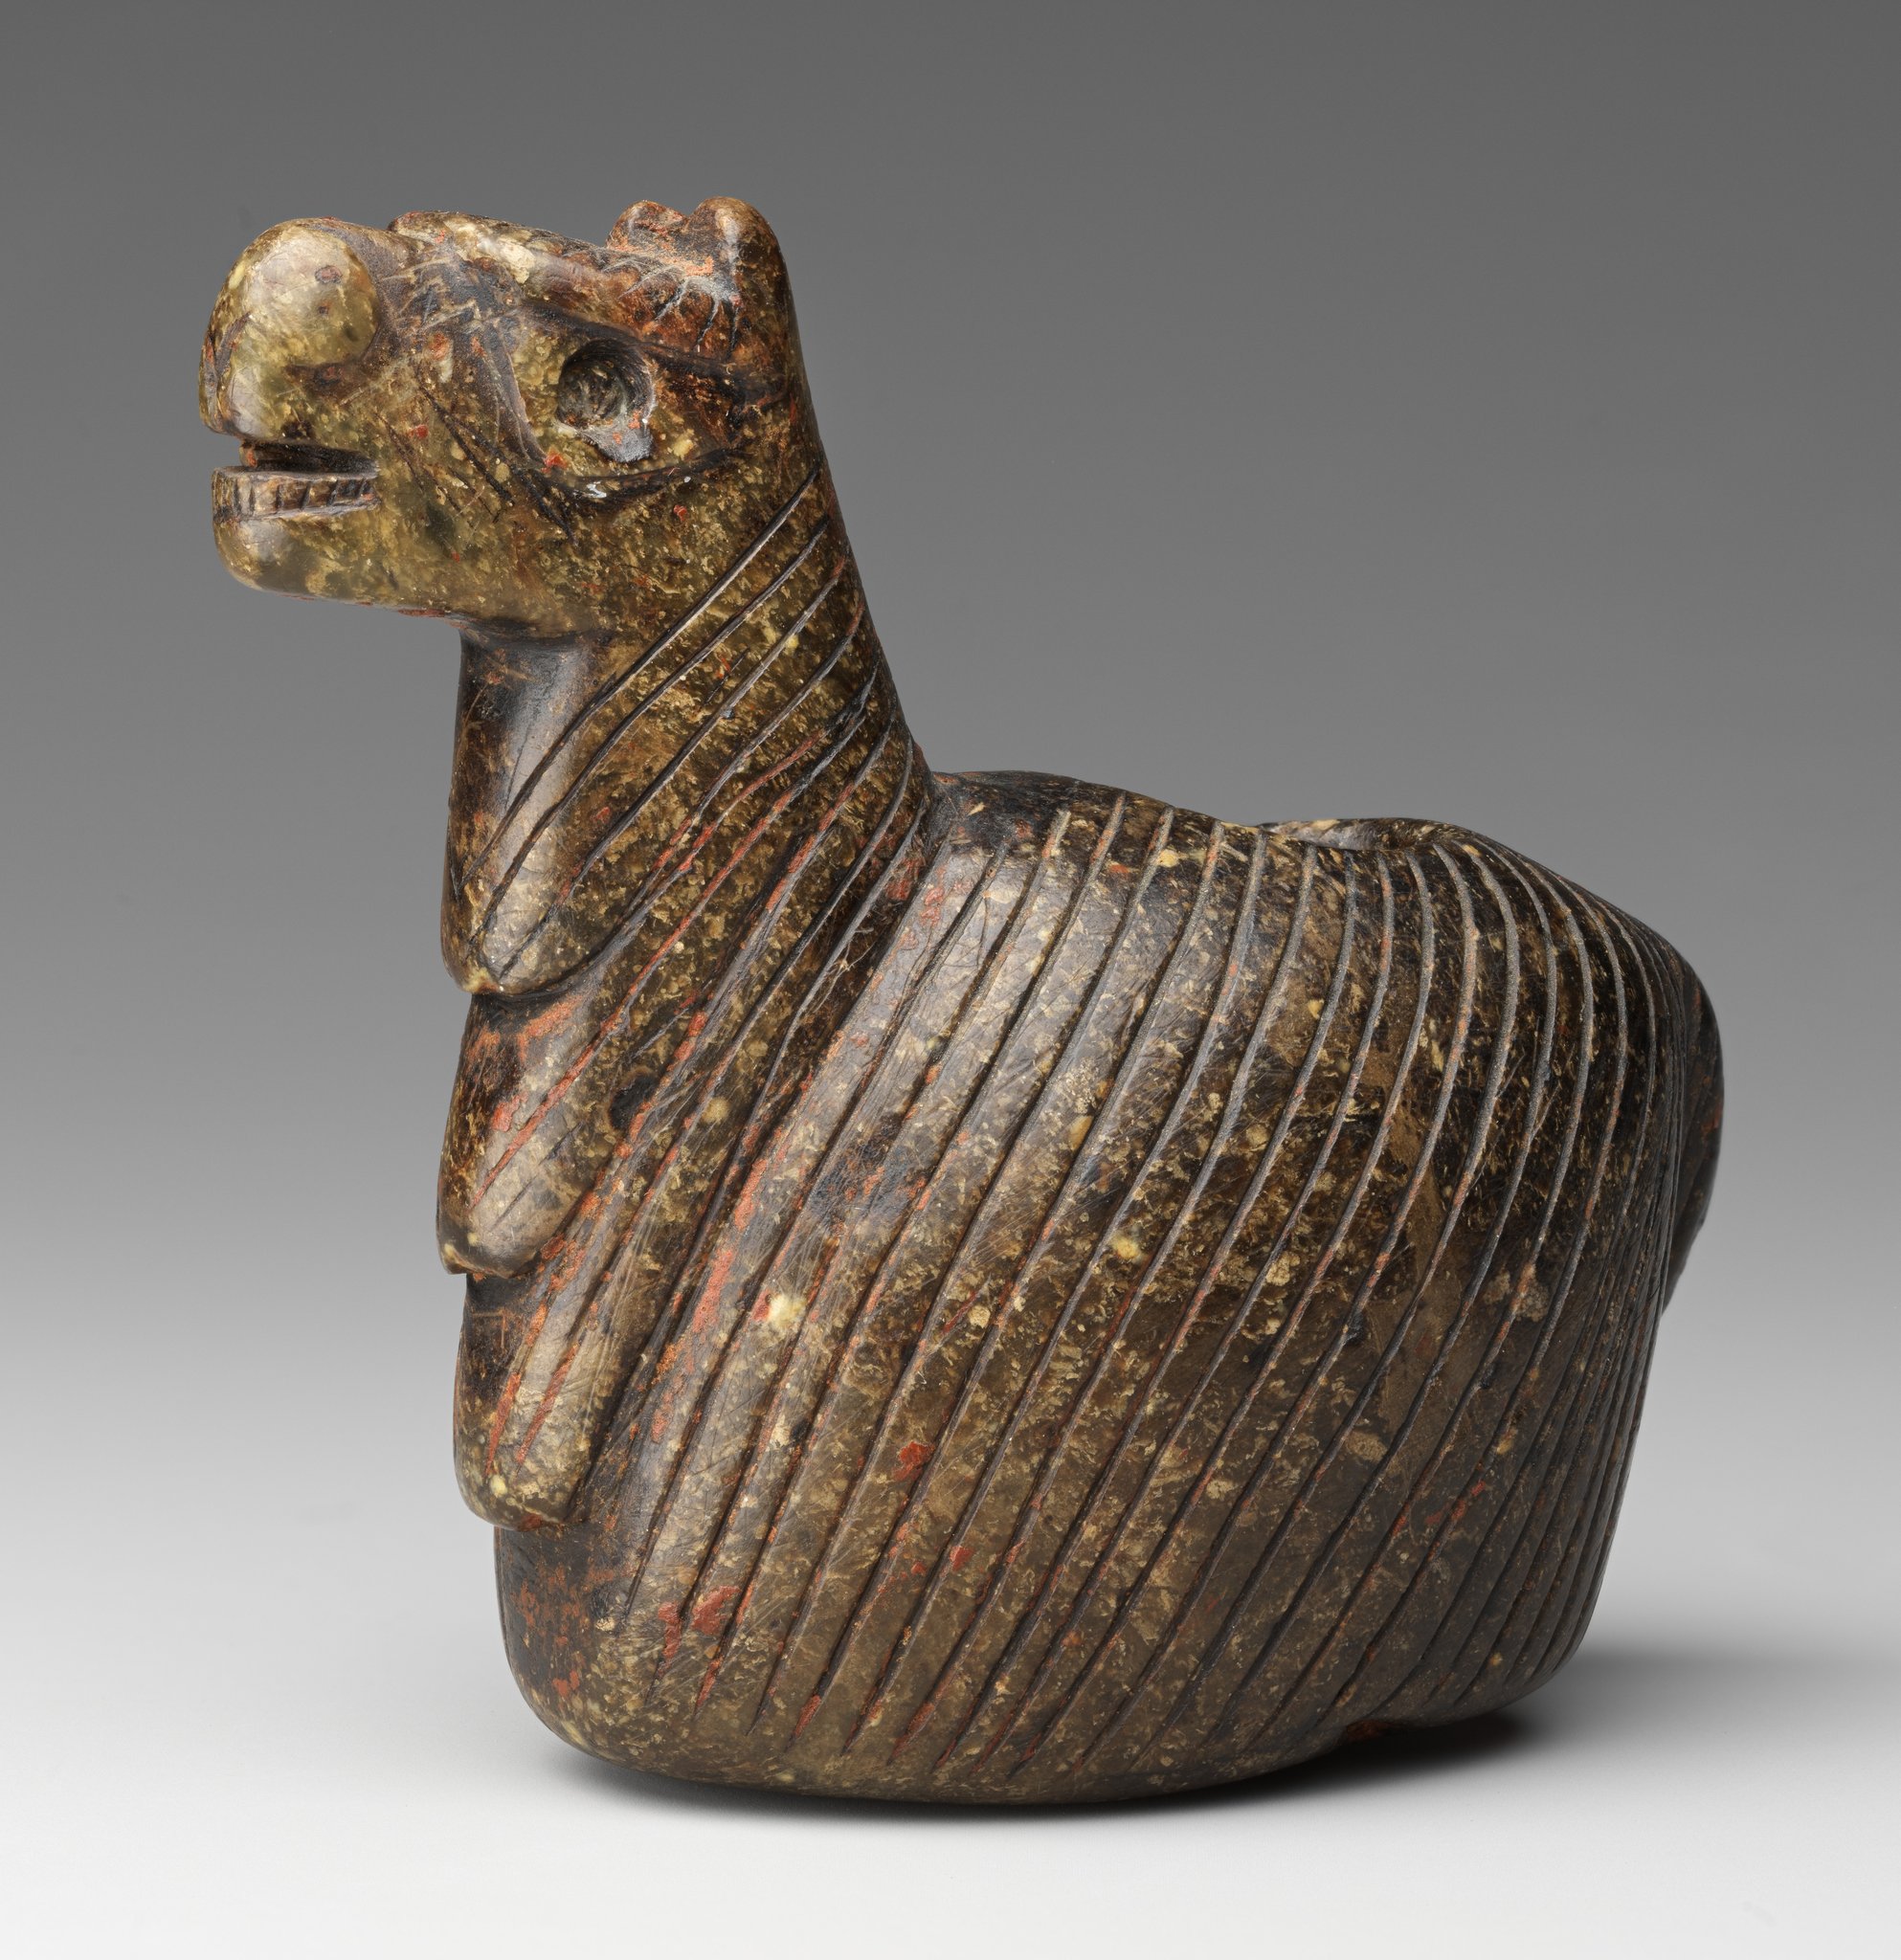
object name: container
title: Conopa (votive effigy)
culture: inca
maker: inca artist(s)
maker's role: artist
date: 1400-1535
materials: stone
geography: peru